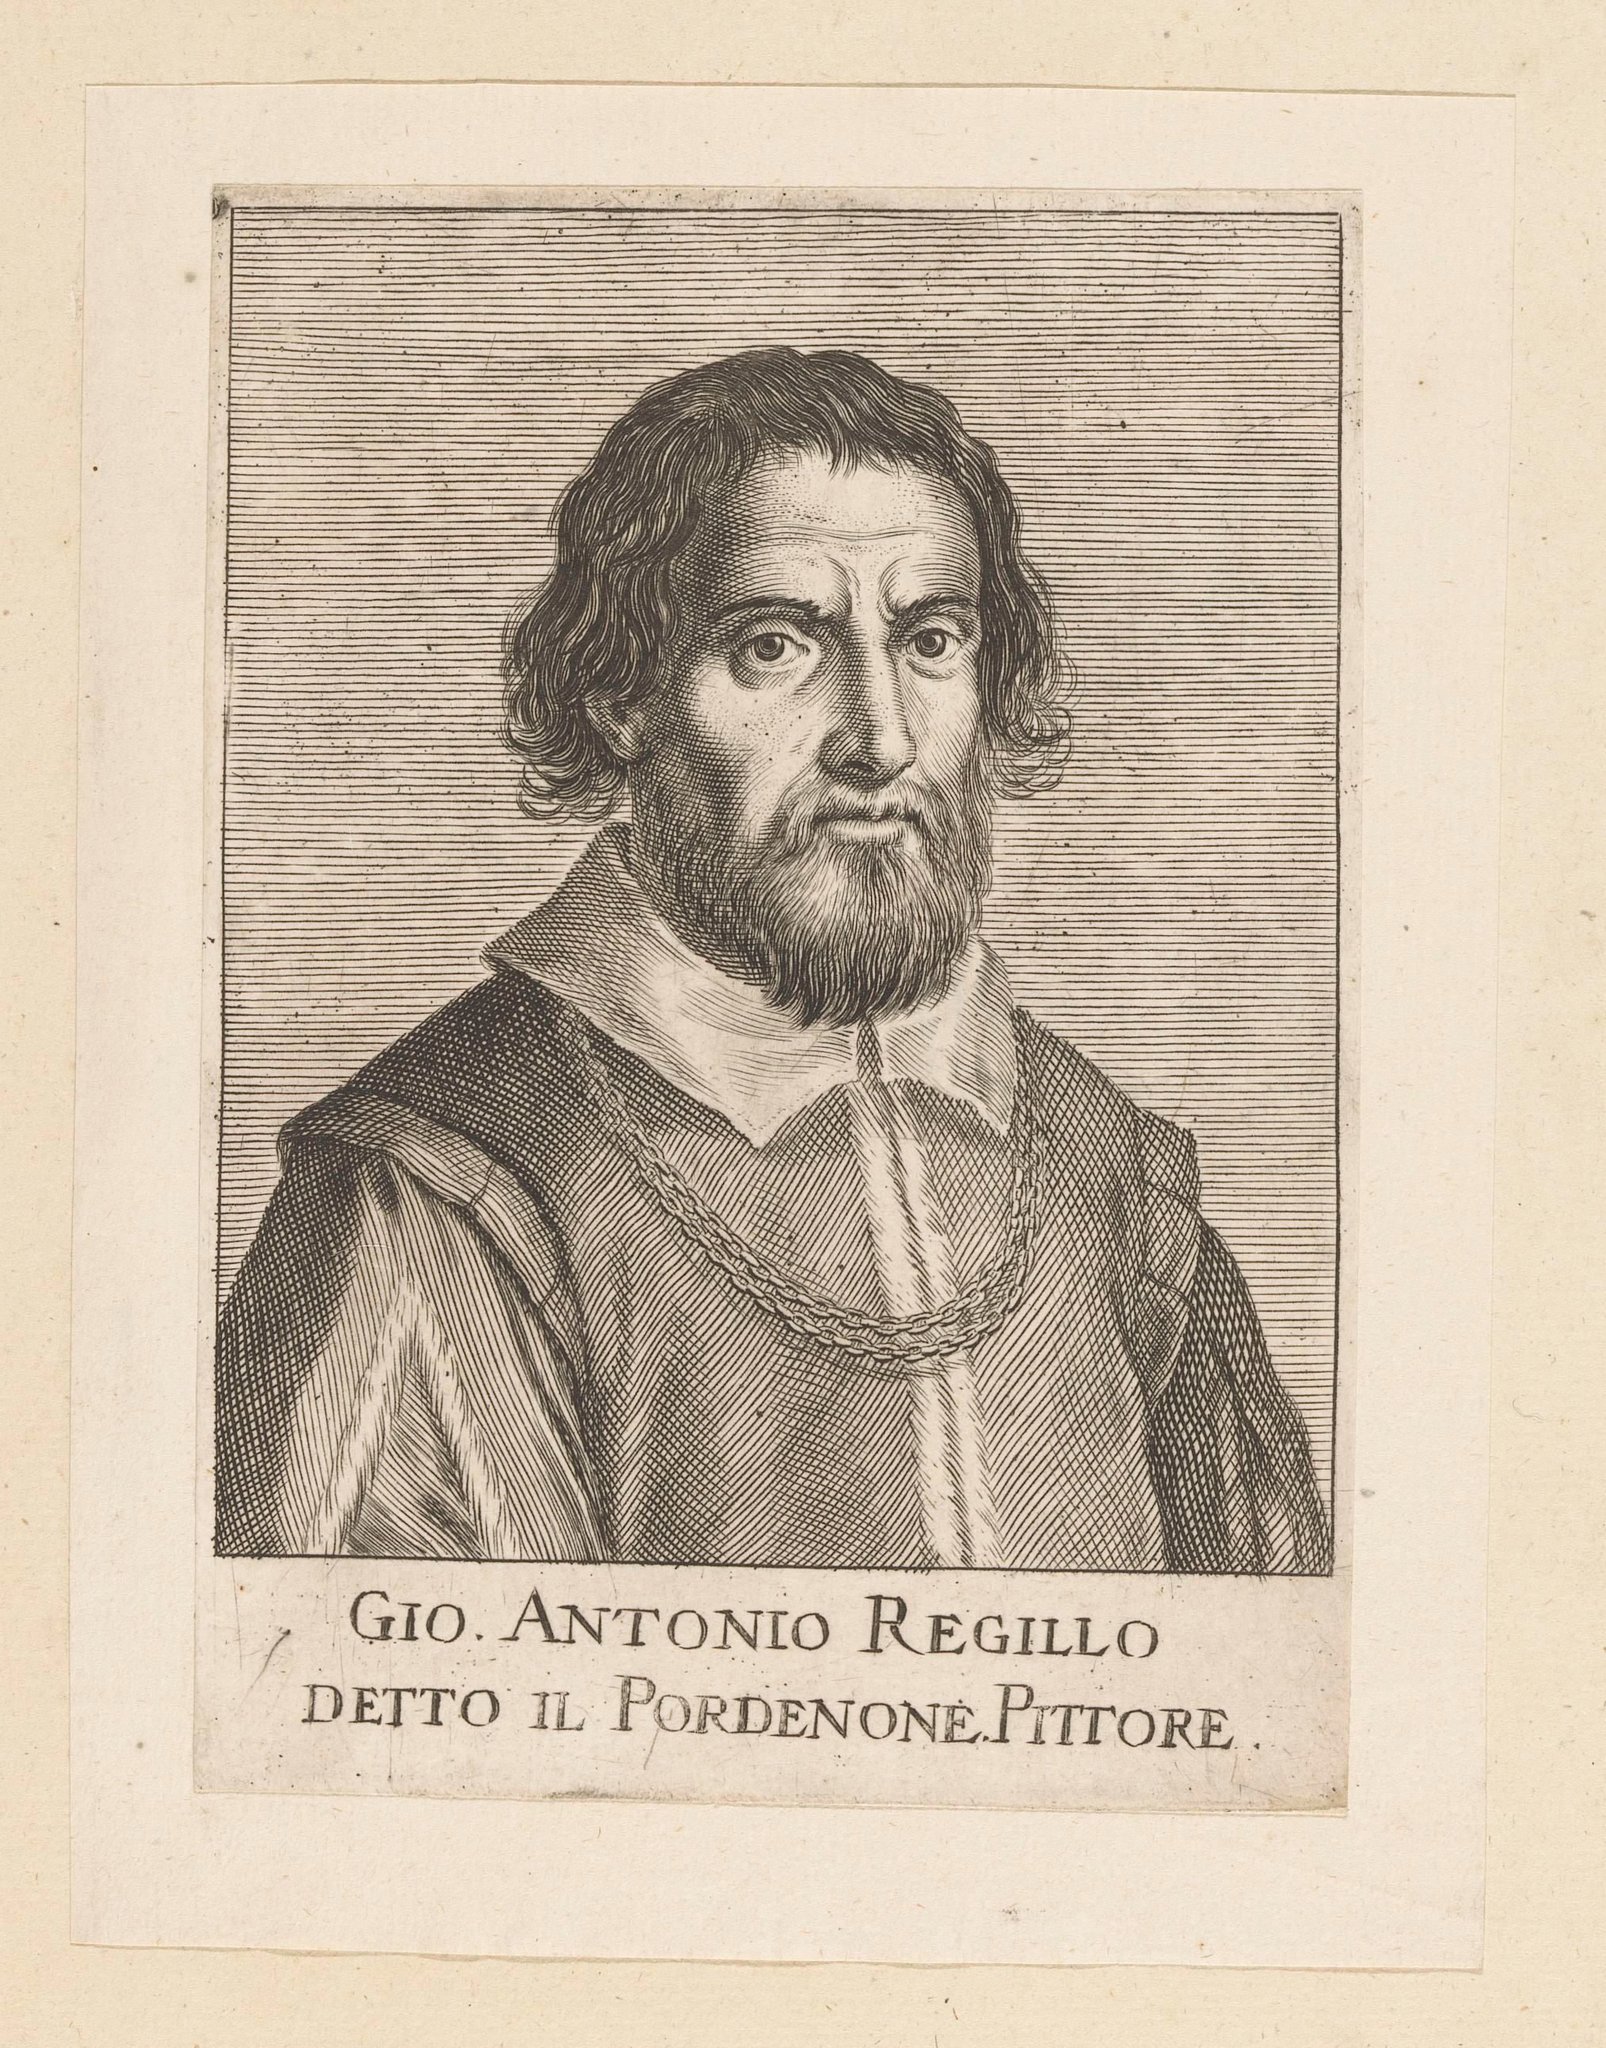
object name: print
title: Portretten van beroemde Italiaanse schilders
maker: monogrammist ip (italië)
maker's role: print maker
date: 1600-1699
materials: paper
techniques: engraving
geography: italy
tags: painter, print maker, draughtsman, pordenone, historical persons, portrait, self-portrait of artist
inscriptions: collector's mark: Lugt 2228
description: Deze prent maakt deel uit van een reeks van ten minste negen portretten van beroemde Italiaanse schilders.